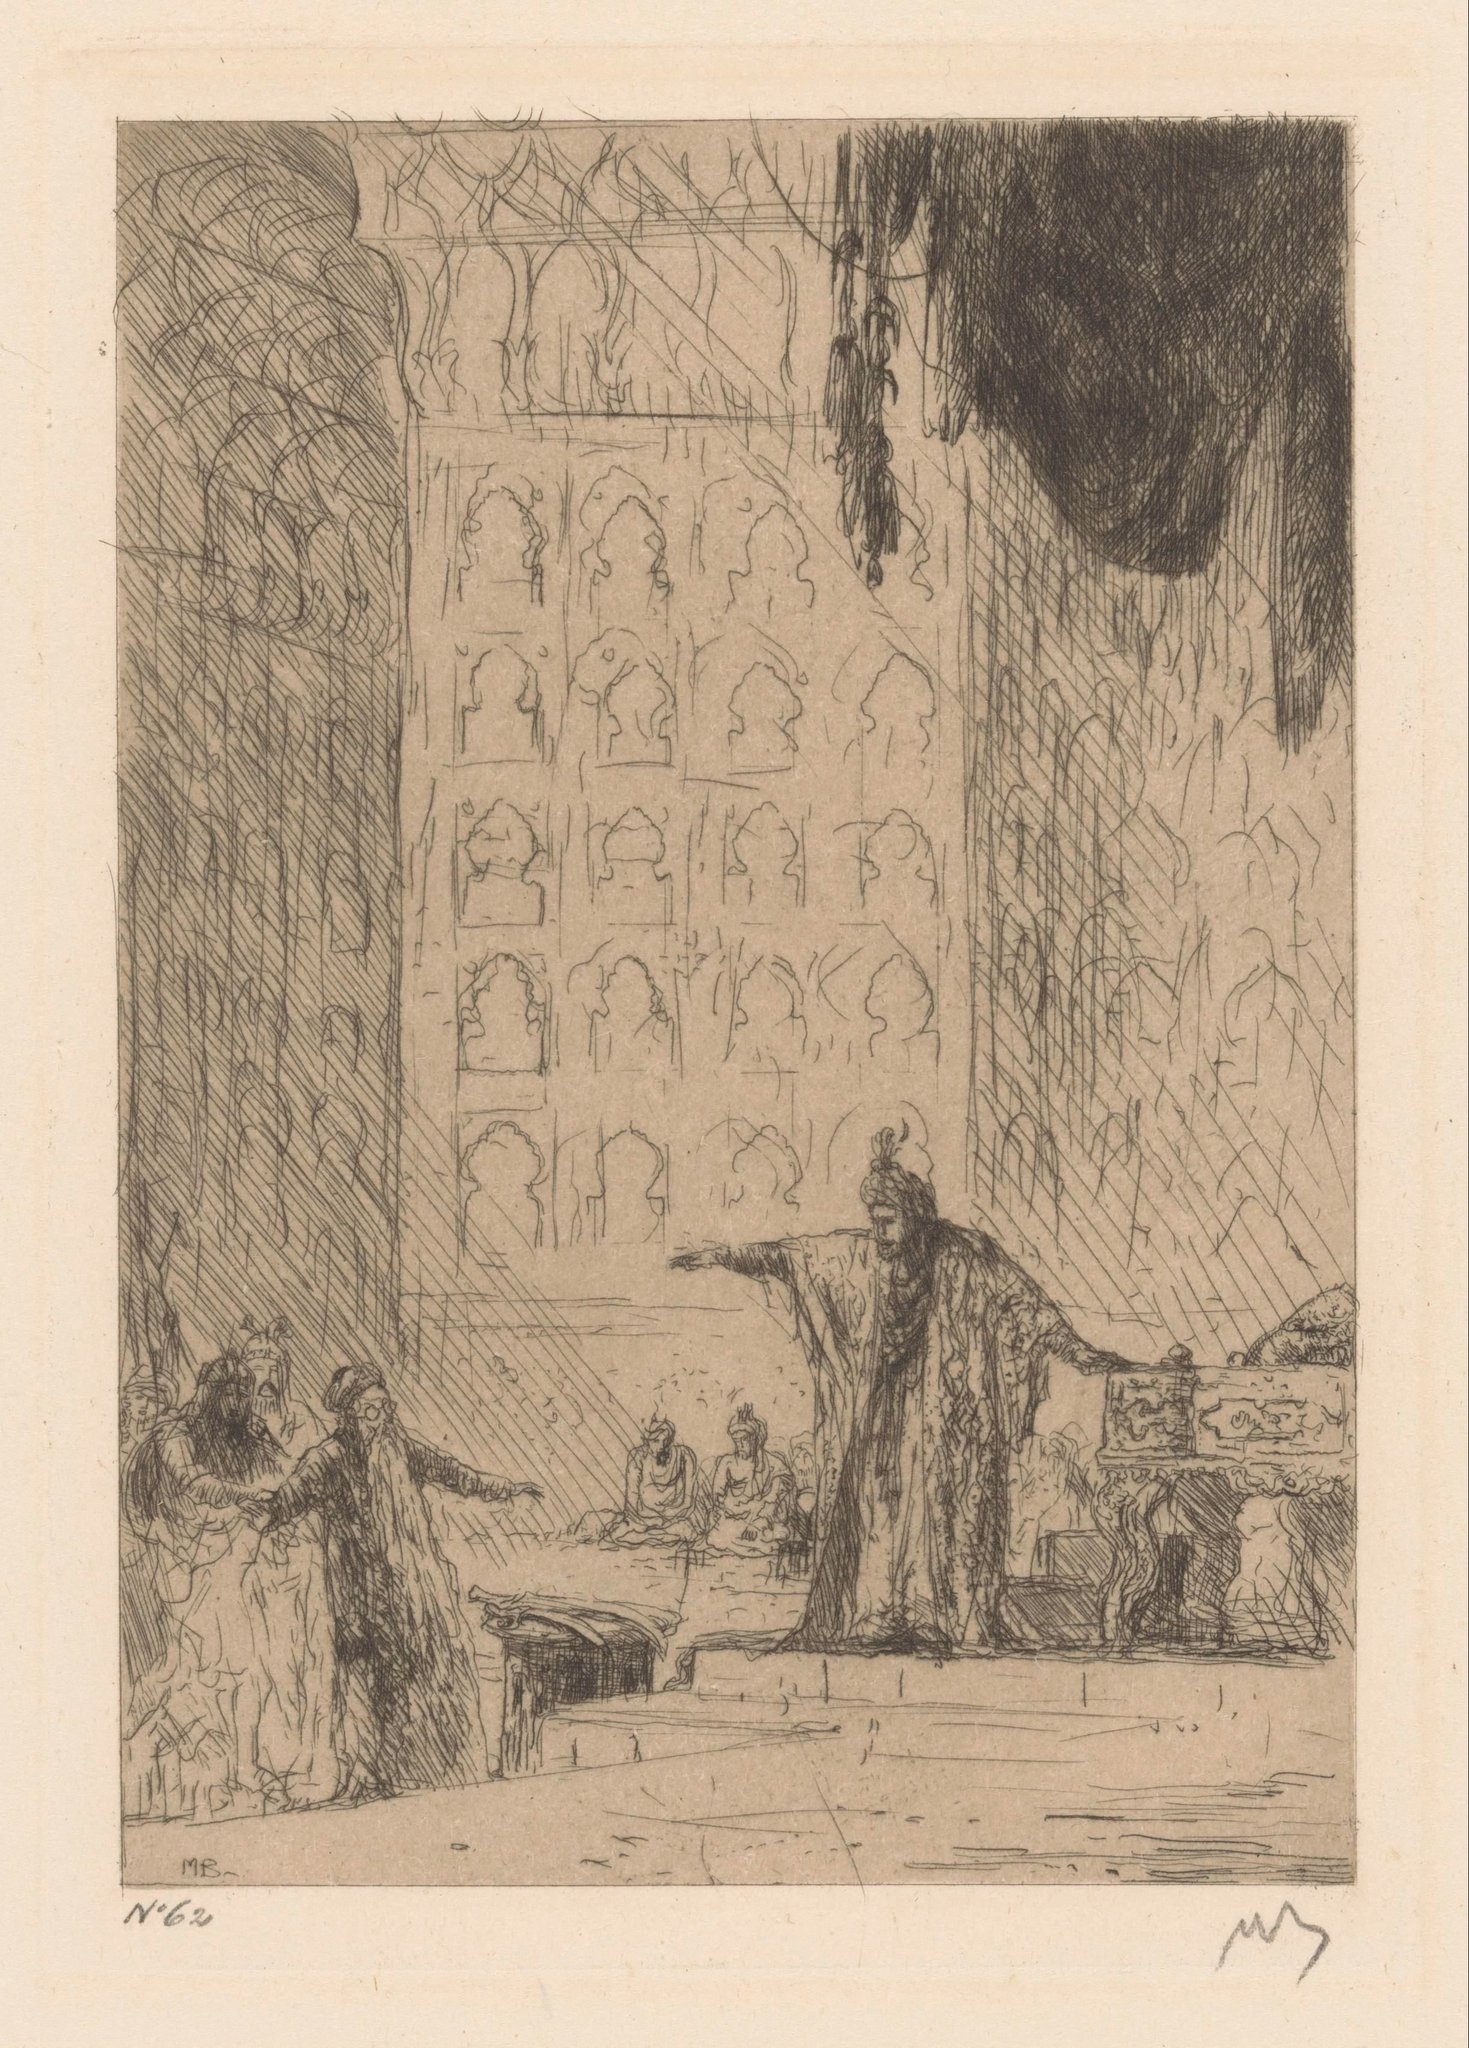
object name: print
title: Vathek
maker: marius bauer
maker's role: draughtsman, print maker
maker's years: 1867-1932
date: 1899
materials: paper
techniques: etching, intaglio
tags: hacking and thrusting weapons: sword, literary characters and objects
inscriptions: collector's mark: Lugt 2228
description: Illustratie bij de gotische roman Vathek (1786) van William Beckford. De kalief Vathek wil weten welke tekst er in gloeiende letters op zijn zwaarden staat geschreven. Hij looft een beloning uit en bestraft iedereen die er niet in slaagt hem het antwoord te geven. Links bewakers van Vathek die een bebaarde man vasthouden, in het midden op een tafel de zwaarden, rechts Vathek zelf die naar de bebaarde man wijst met uitgestoken arm.